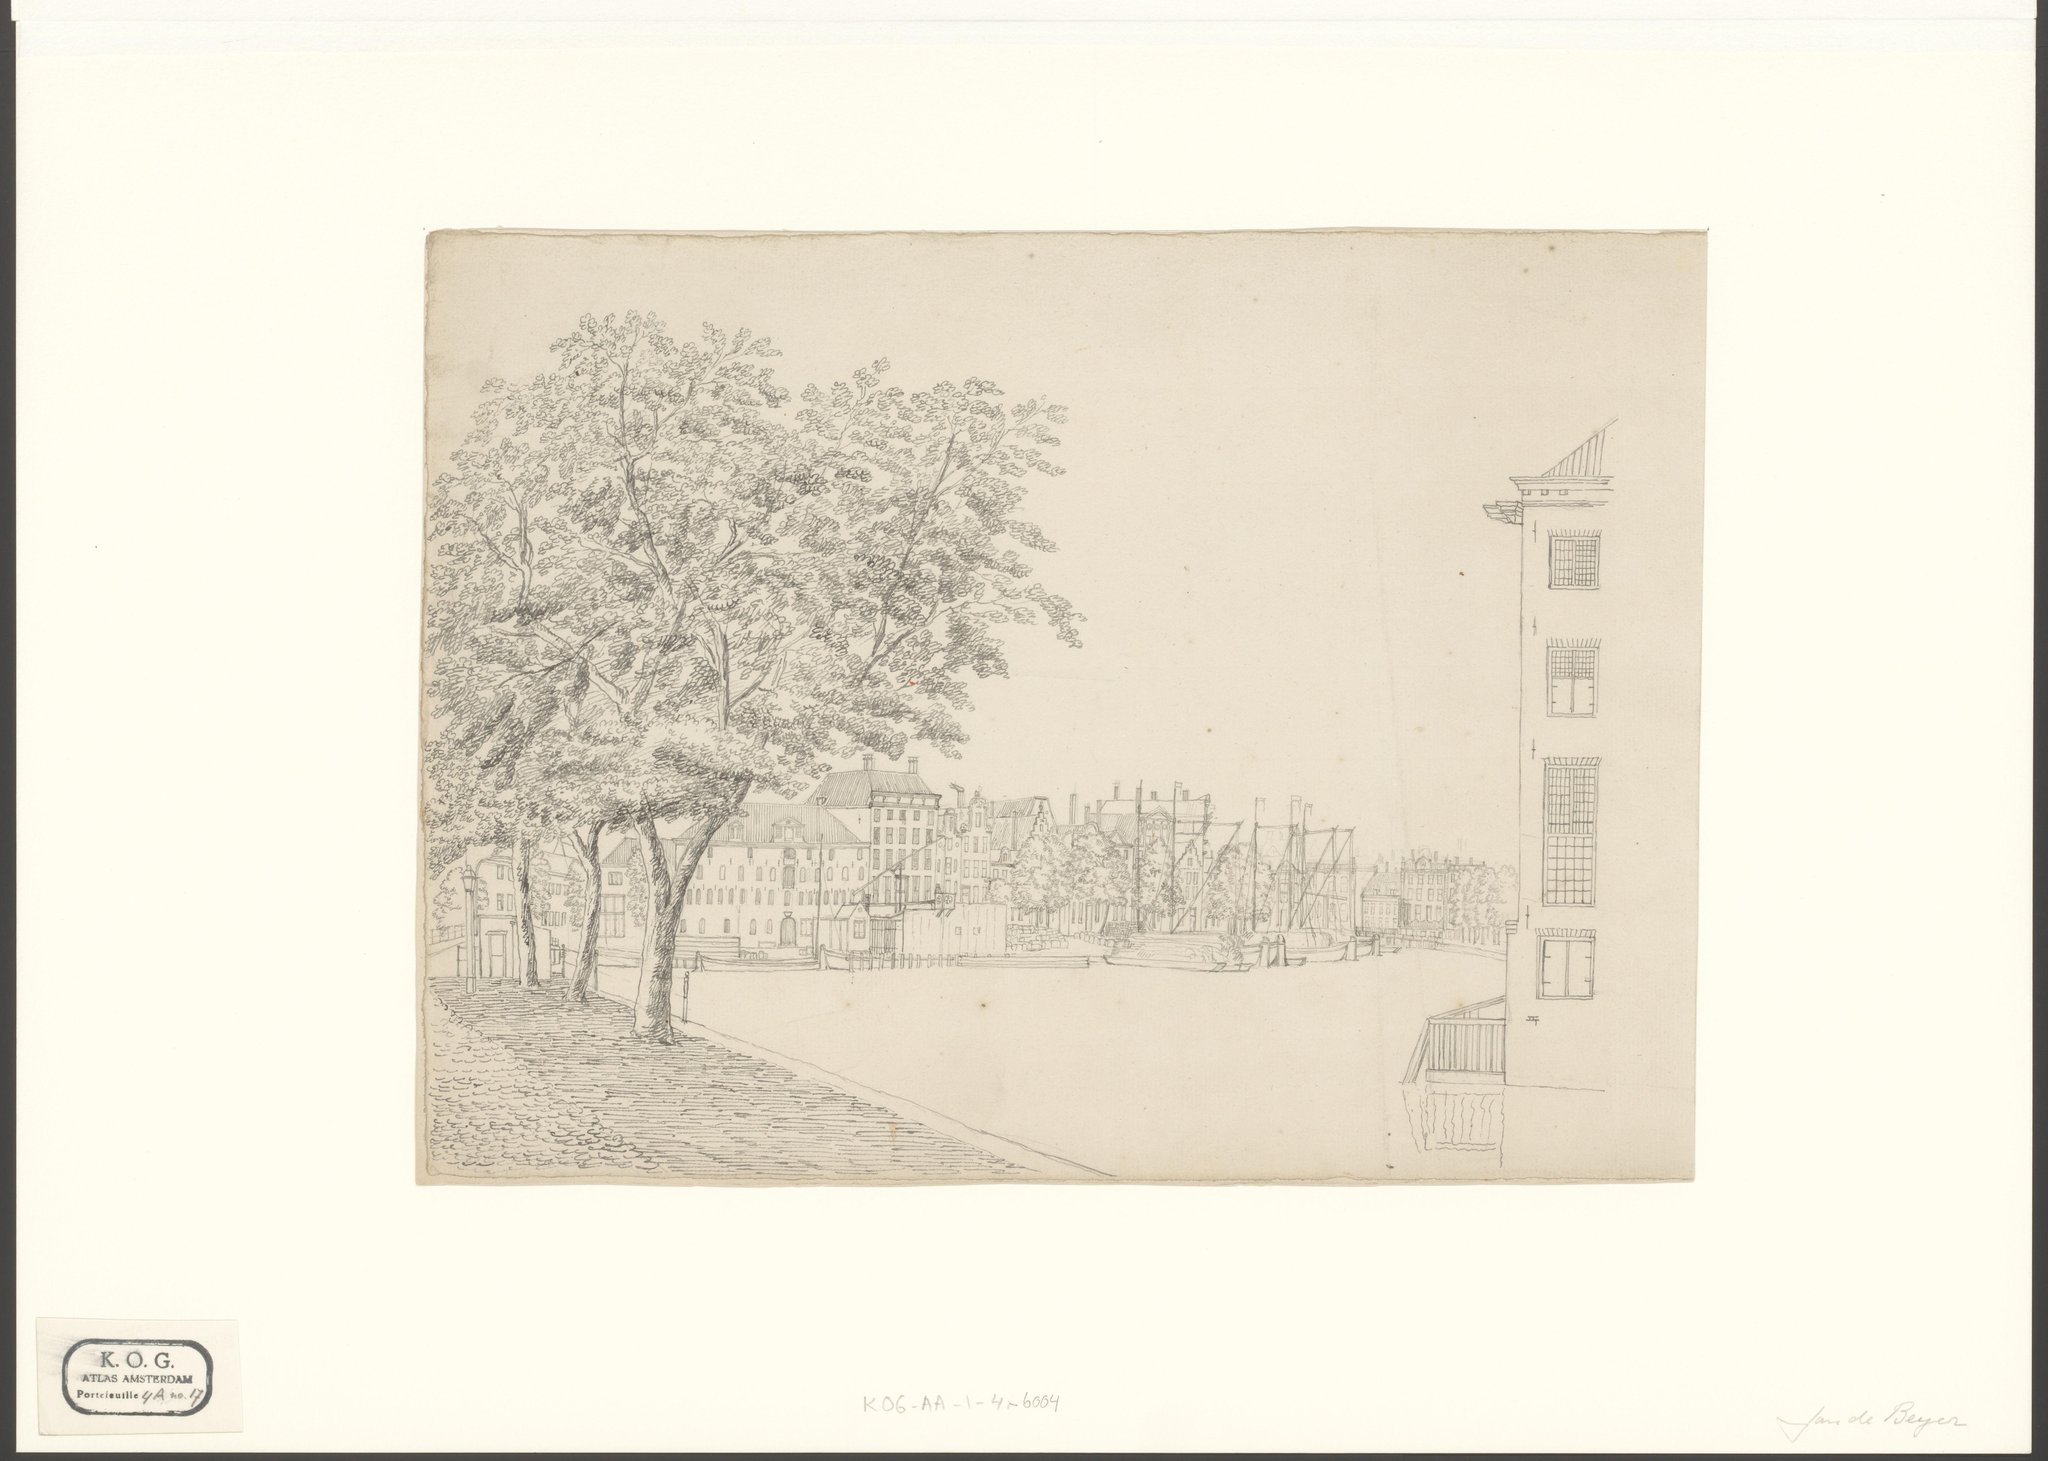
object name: drawing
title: Gezicht op brouwerij De Drie Roskammen gezien vanaf de Binnen-Amstel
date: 1750-1799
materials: ink, paper, pencil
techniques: pen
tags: city-view in general; 'veduta', canal, the usual house or row of houses, street, amsterdam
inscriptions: name: ‘Jan de Beyer’, collector's mark: ‘4A no 17’ Lugt 1641b, inscription: ‘f 1;25 / Gezicht op de Brouwerij de Drie roskammen / a/d Binnenamstelb/[...] Amsterdam / Port 4’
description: Onderwerpsrubriek binnen de Atlas Amsterdam: Amstel van Doelensluis tot Blauwbrug.